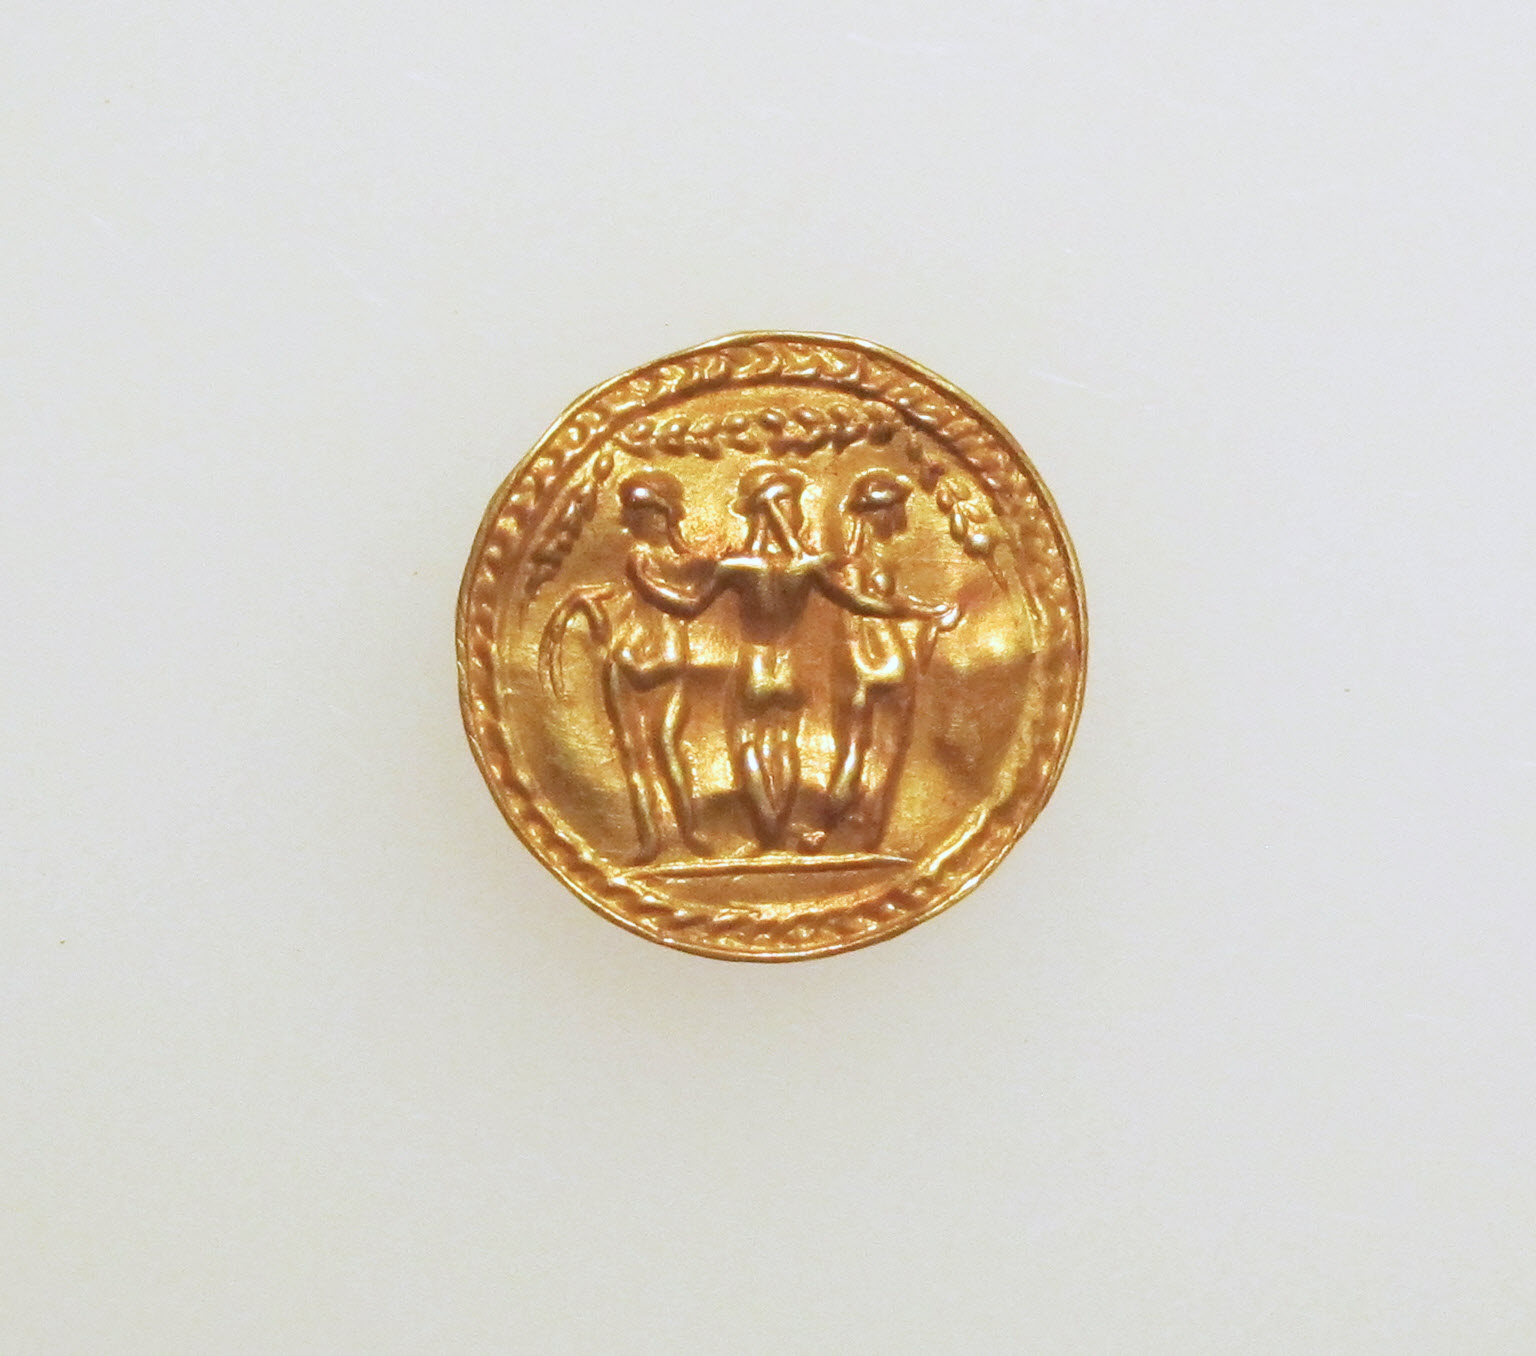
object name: roundel, disk with three grace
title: Roundel, disk with three graces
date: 400-301 BCE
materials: gold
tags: women